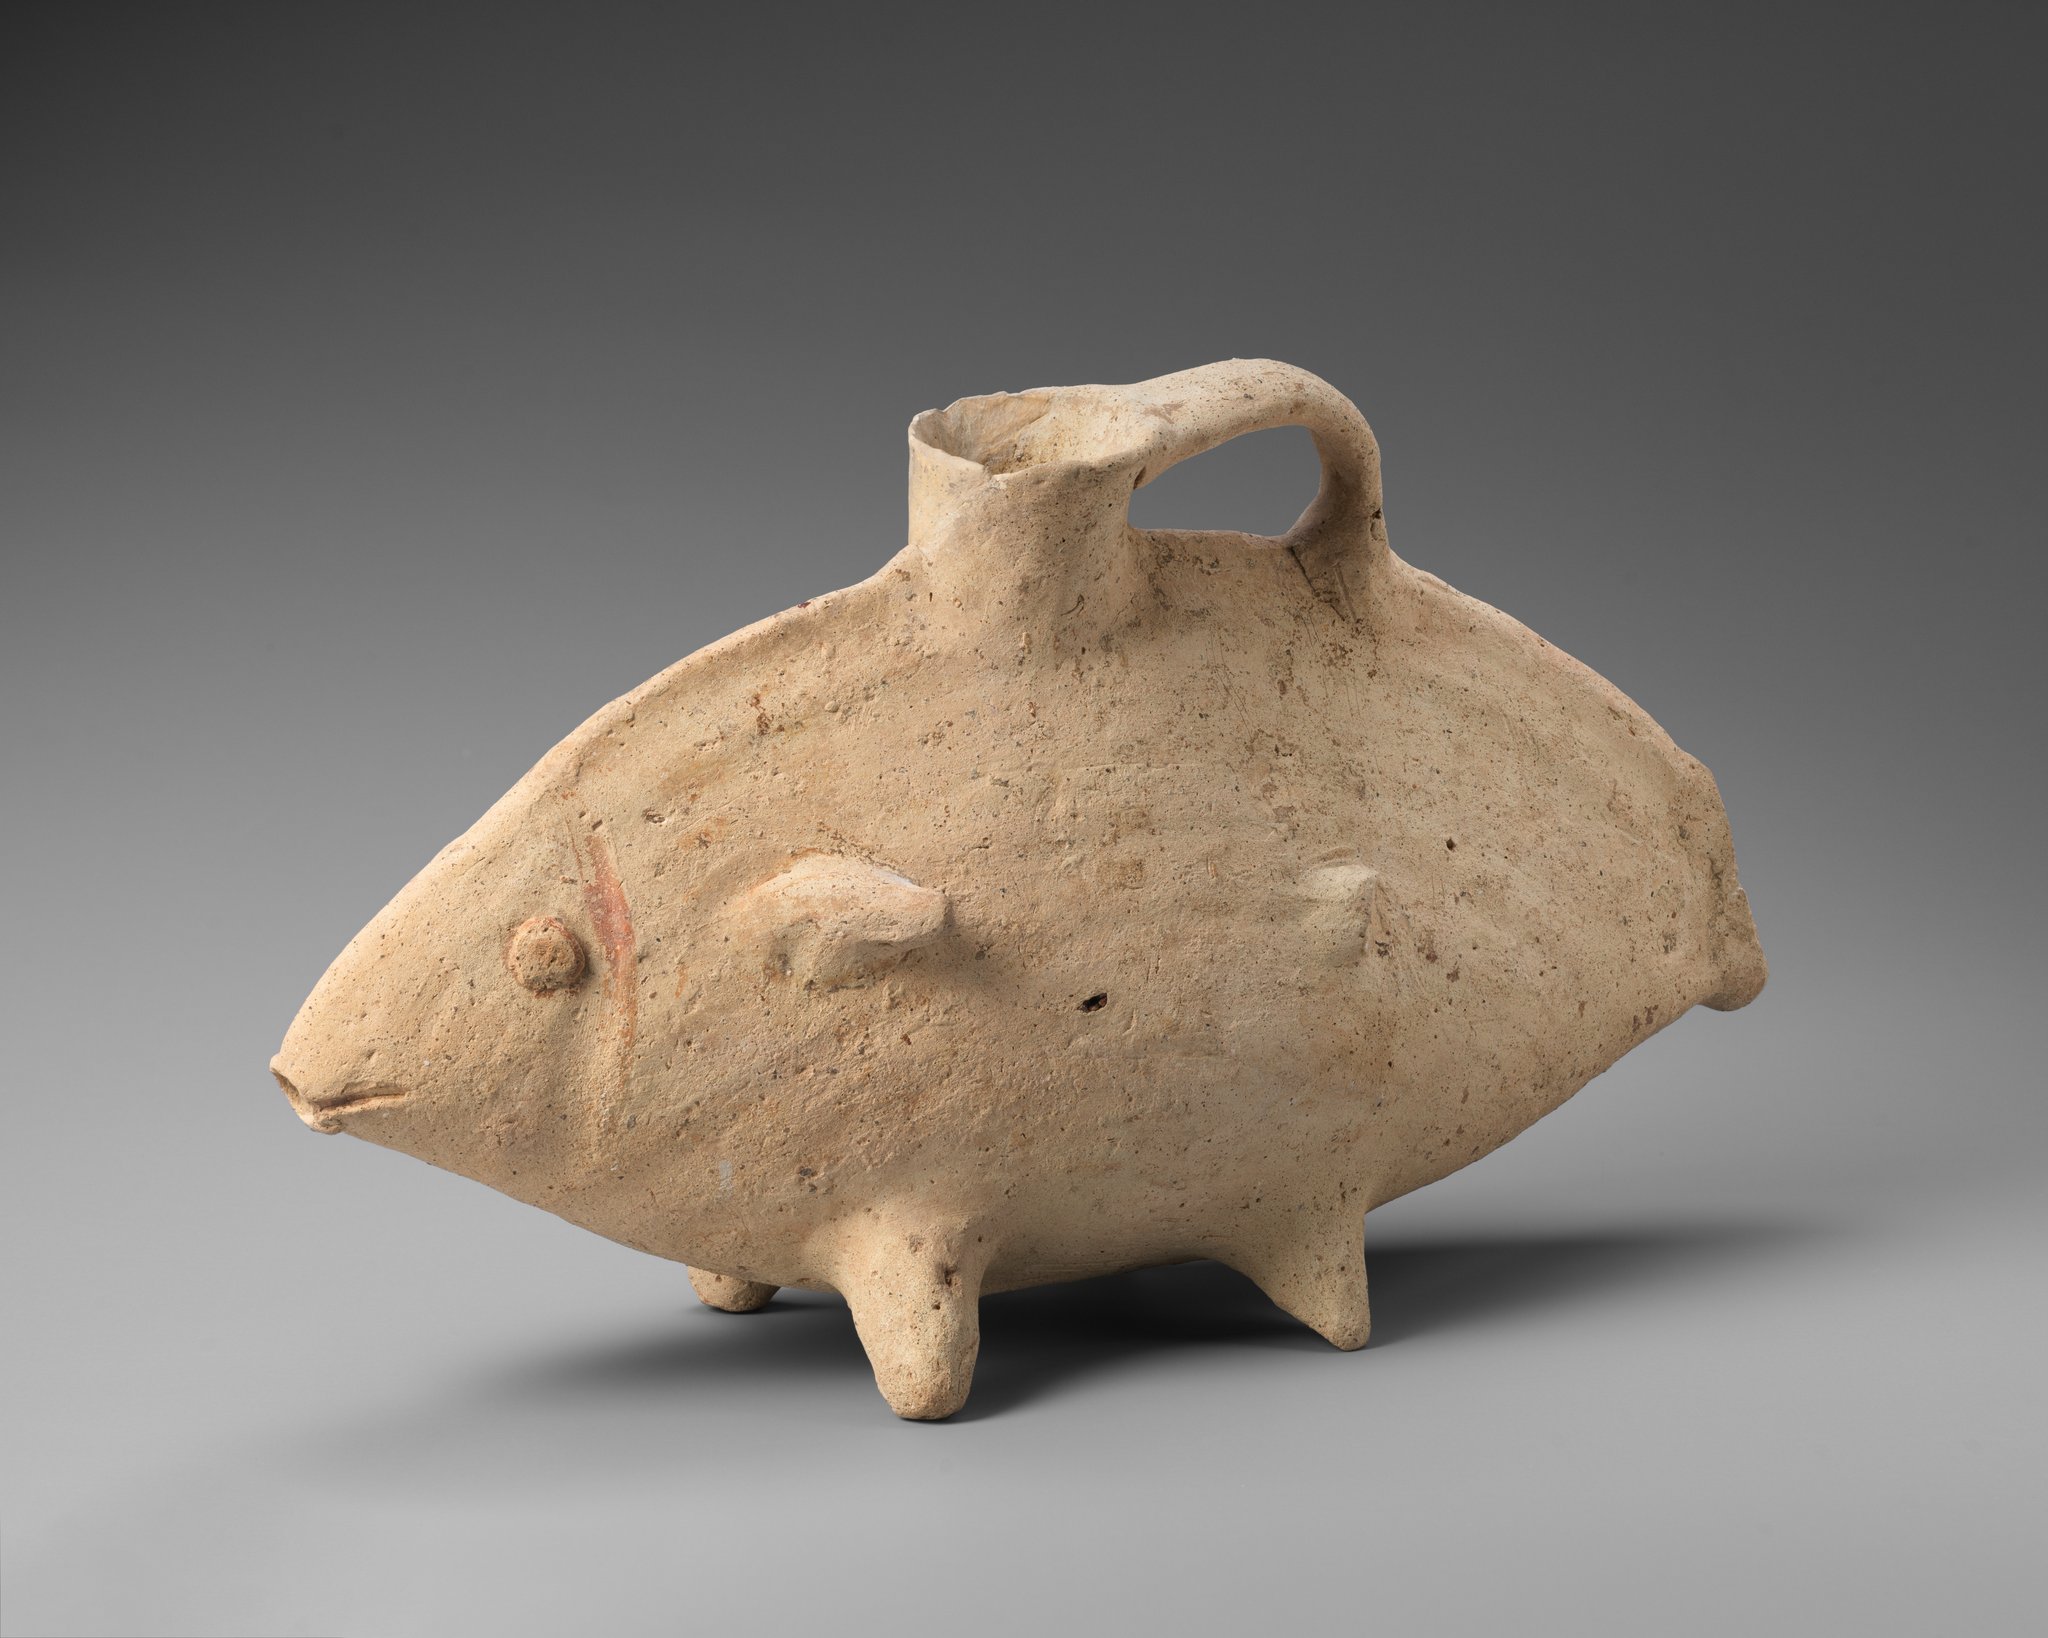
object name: askos in the form of a fish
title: Terracotta askos (vessel) in the form of a fish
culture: cypriot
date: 1200-1175 BCE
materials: terracotta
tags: fish